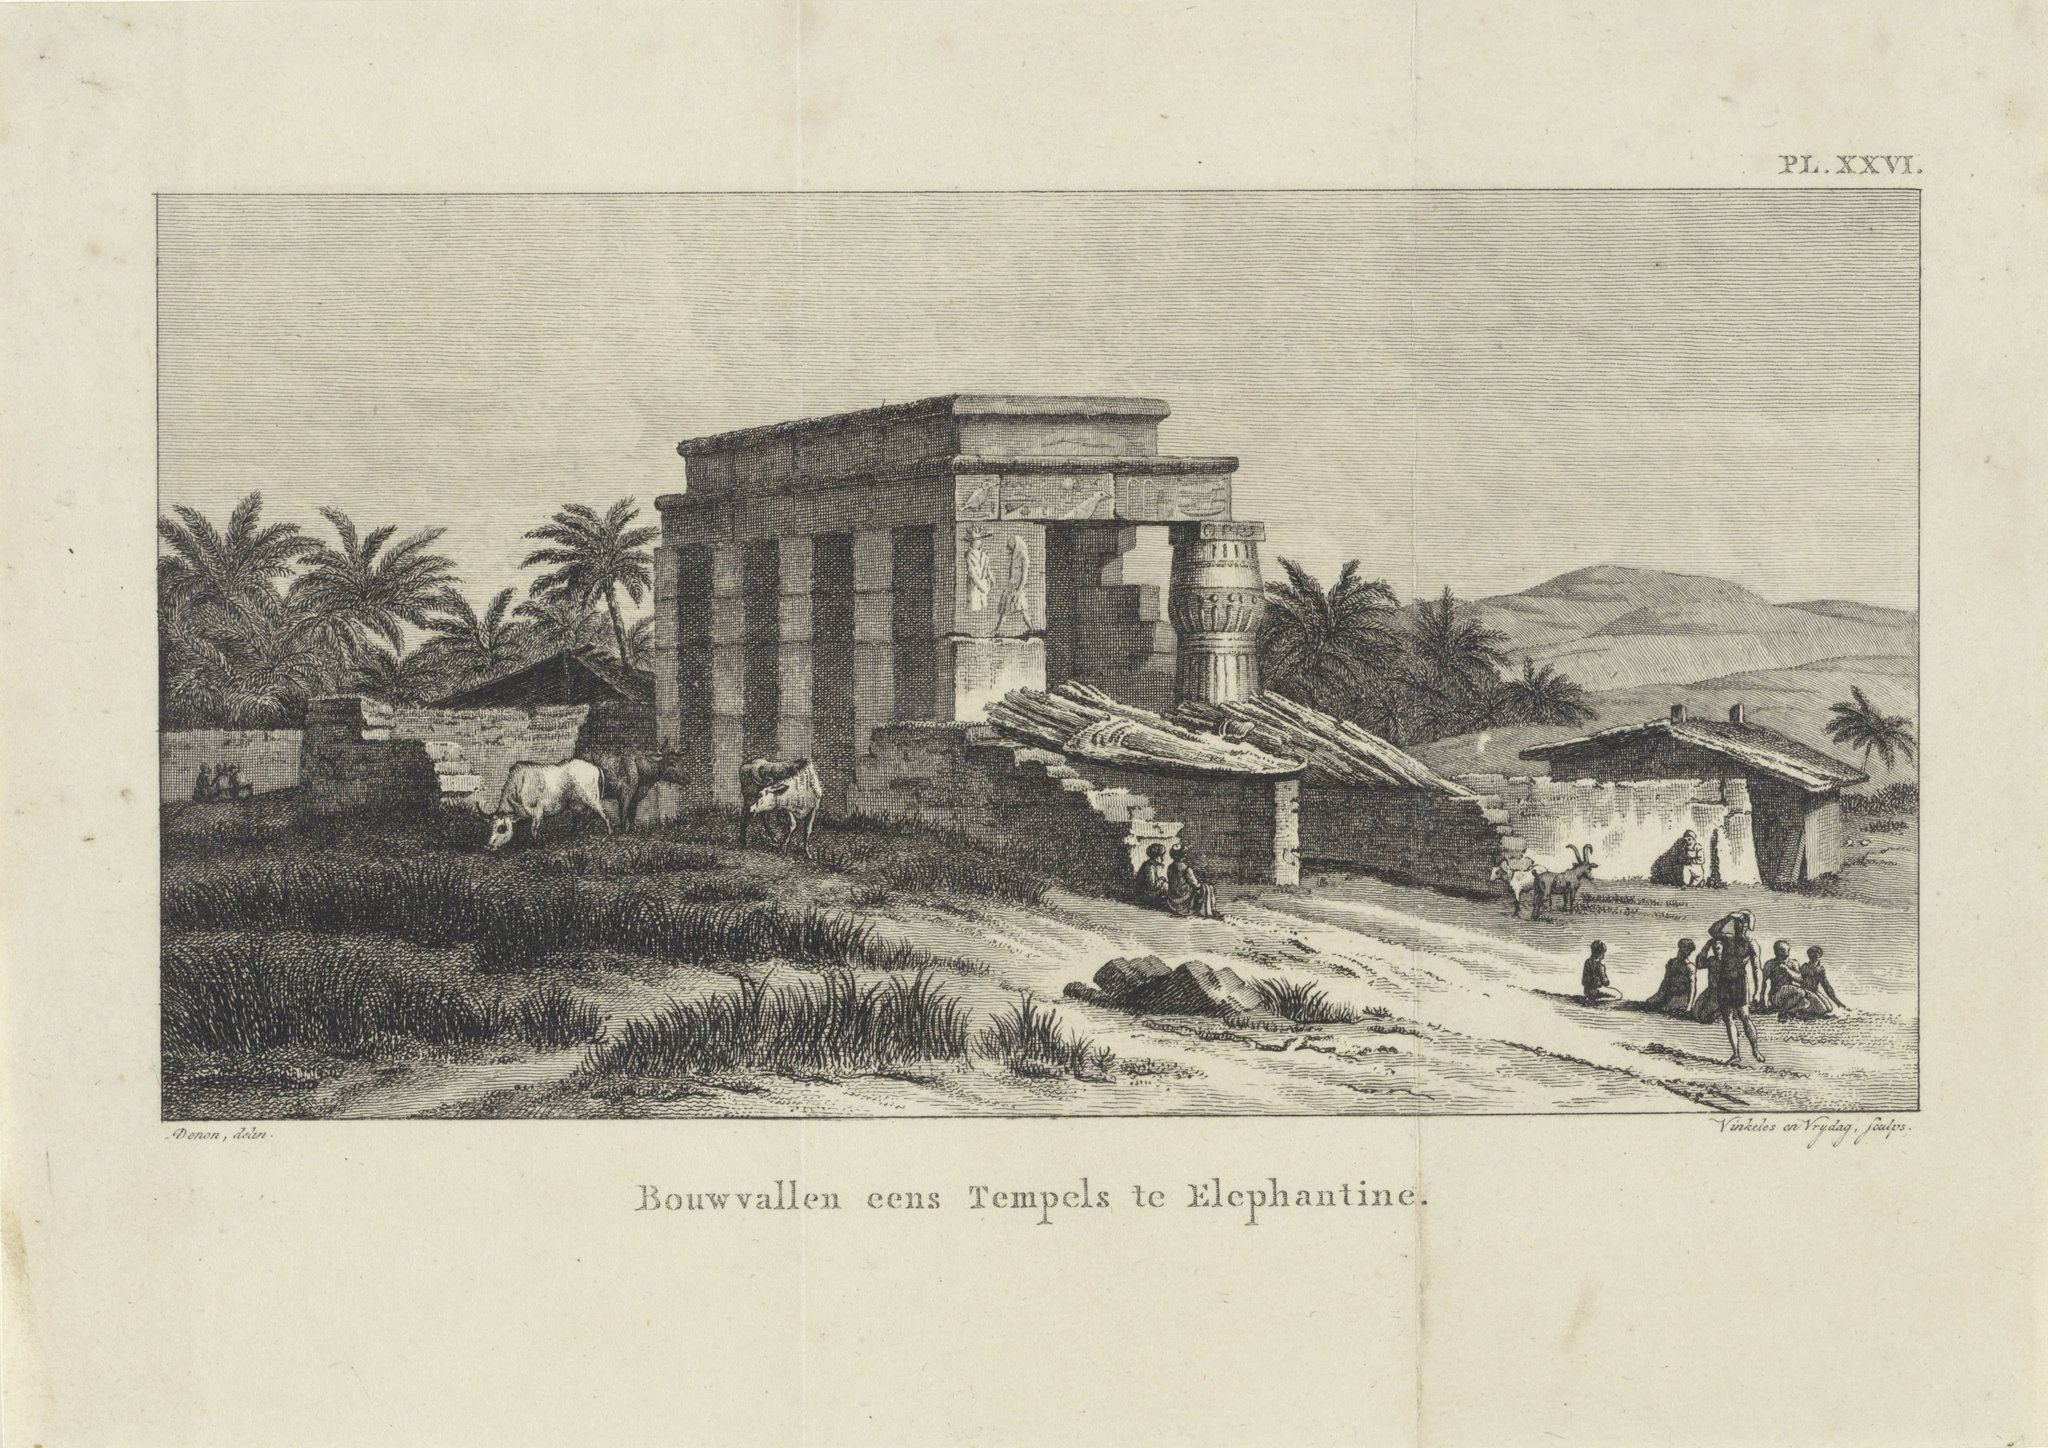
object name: book illustration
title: Bouwvallen eens Tempels te Elephantine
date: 1803-1805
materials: paper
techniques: etching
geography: amsterdam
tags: temple, shrine ~ egyptian religion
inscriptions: collector's mark: Lugt 2228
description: Prent vermoedelijk gebruikt in: Denon, Dominique Vivant [vertaald door Herman Bosscha]. Reize in Opper- en Neder-Egipte, gedurende den veldtocht van Bonaparte. 3 dln. Amsterdam: Johannes Allart, 1803-1805.